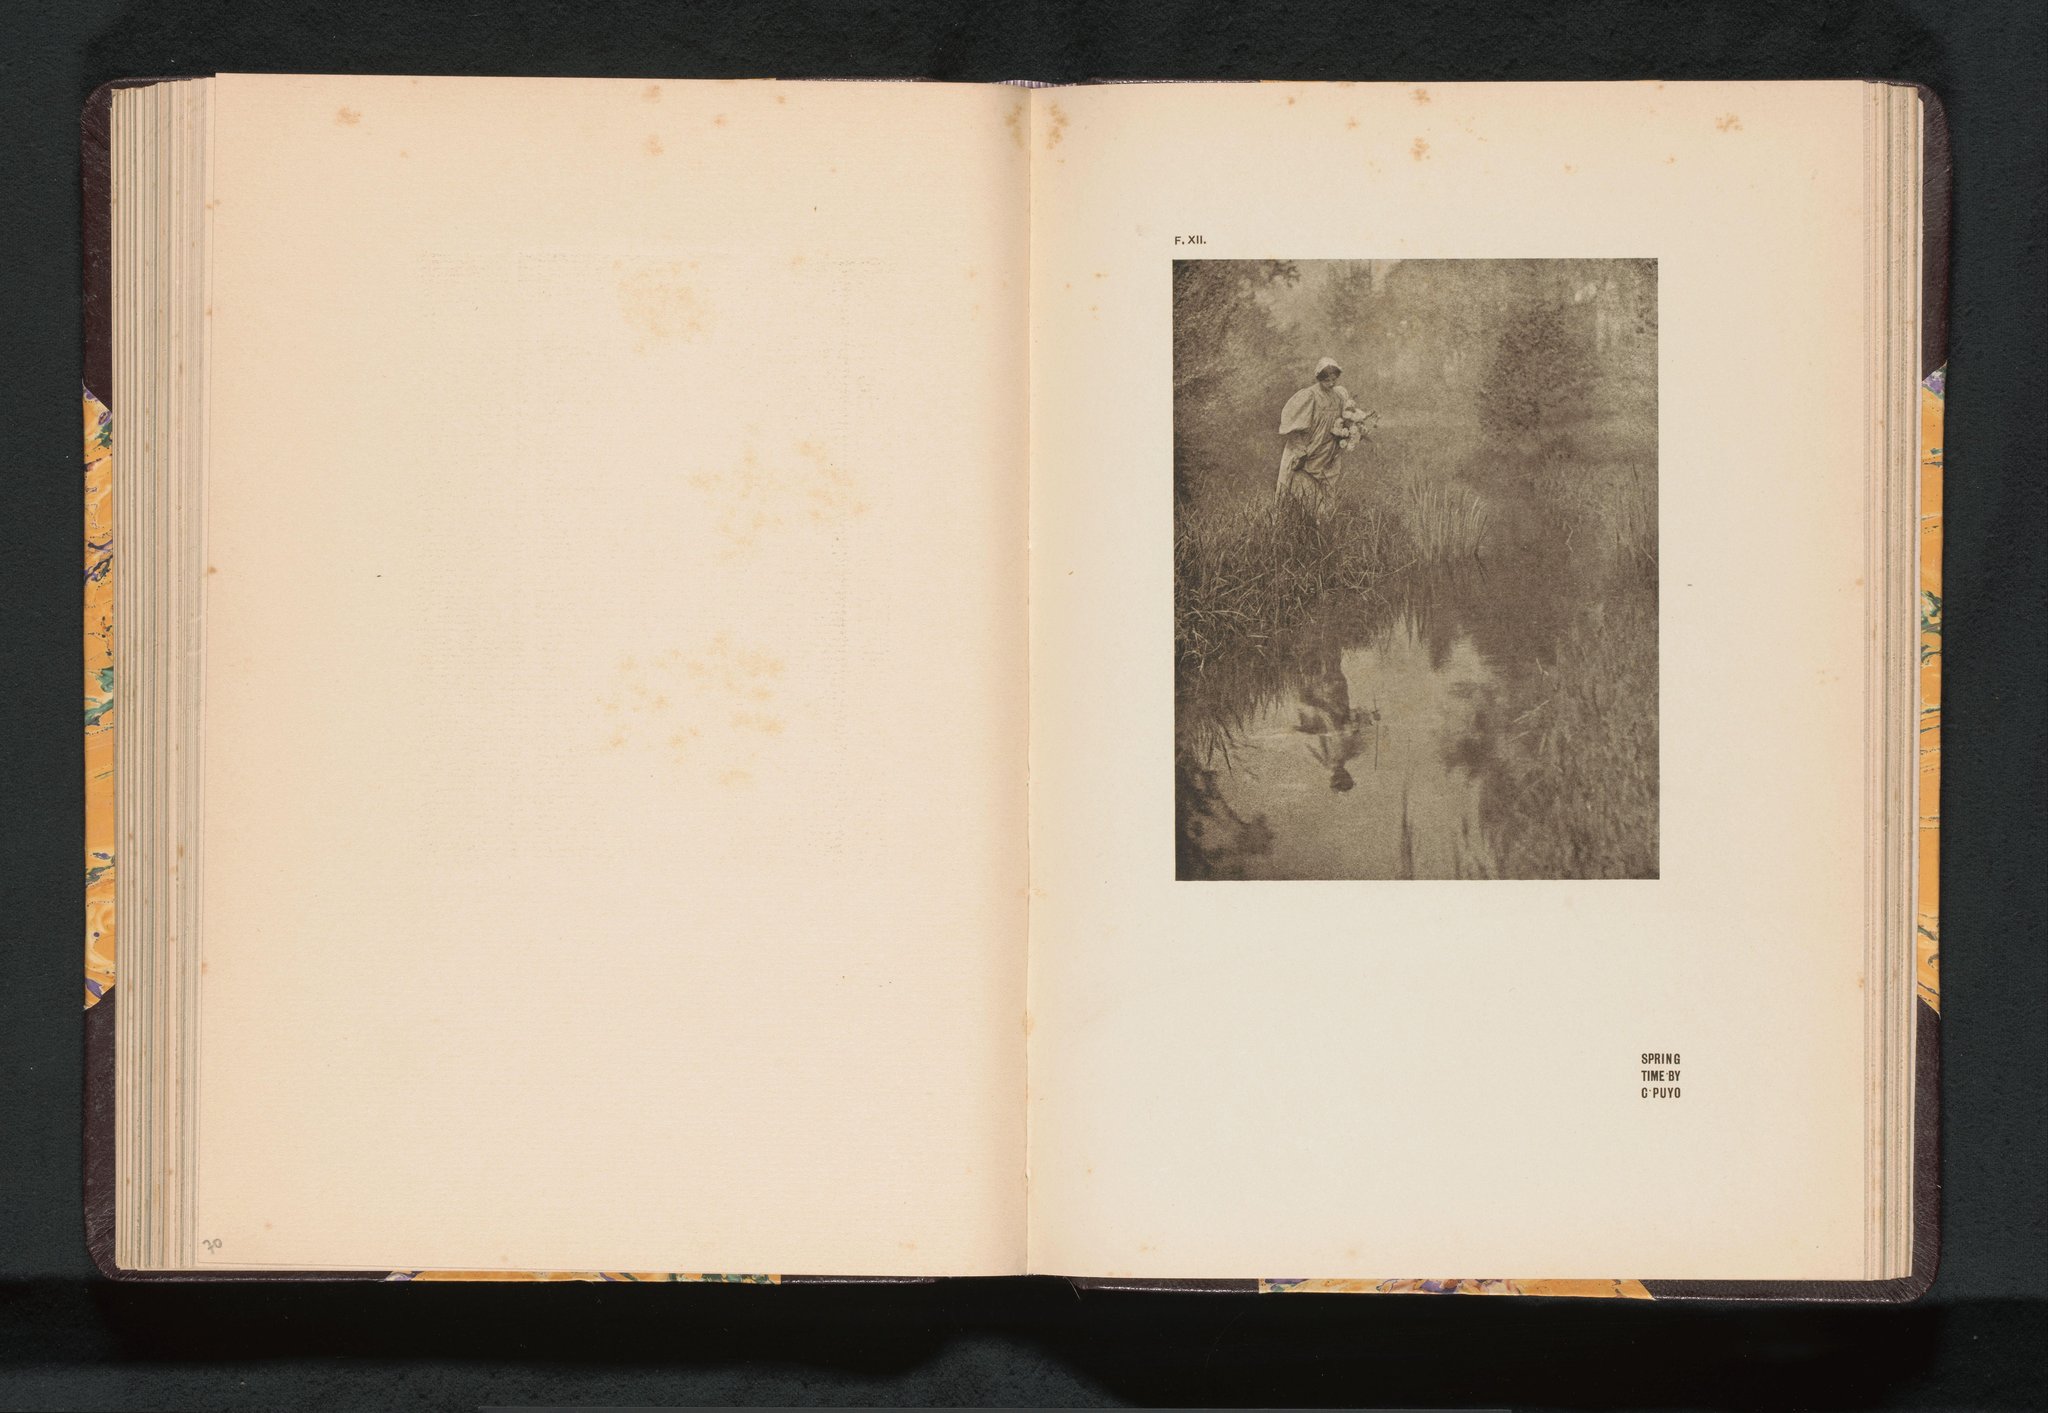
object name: photomechanical print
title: Vrouw plukt bloemen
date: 1900-1905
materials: paper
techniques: autotype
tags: picking flowers, adult woman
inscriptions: inscription: ‘F. XII.’, inscription: ‘Spring time by C. Puyo’